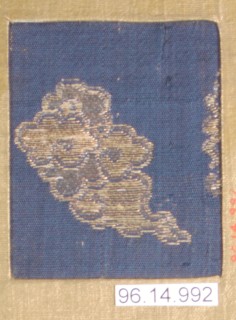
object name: piece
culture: japanese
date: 1701-1900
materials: silk